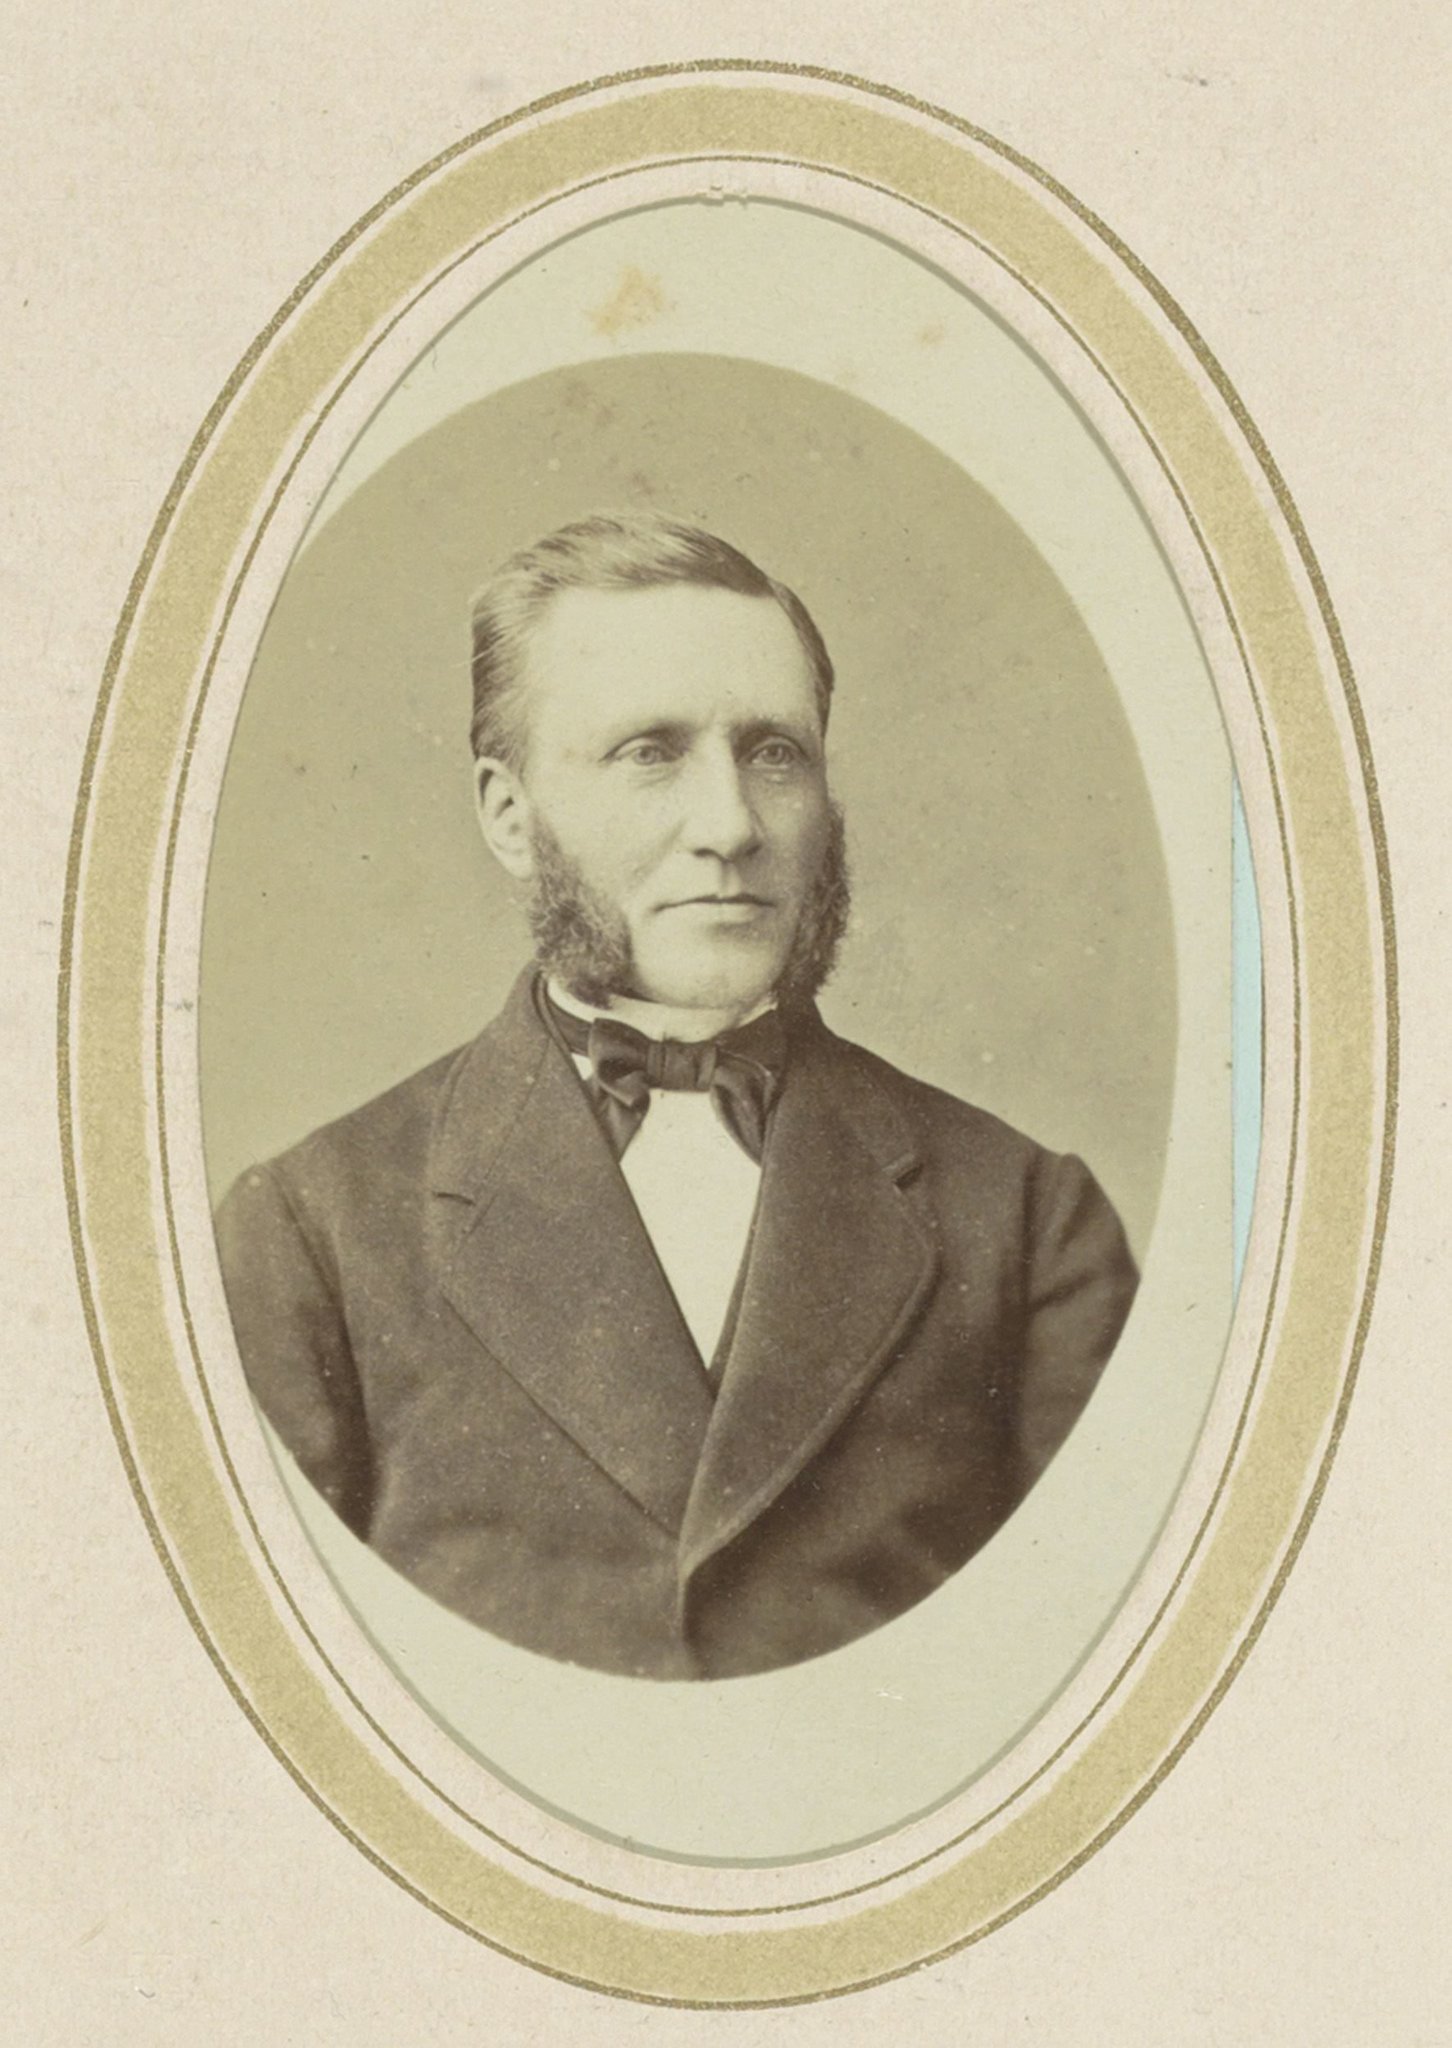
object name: photograph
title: Portret van een man met bakkebaarden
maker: johan christiaan reesinck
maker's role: fotograaf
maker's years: 1838-1922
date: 1866-1900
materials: cardboard, paper, photographic support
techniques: albumen print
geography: zutphen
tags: sideburns, historical persons, neck-gear ~ clothing, clothing for the upper part of the body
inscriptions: address: ‘Zutphen Berkelkade’, address: ‘Arnhem’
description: Onderdeel van Fotoalbum van een Nederlandse familie met 168 cartes-de-visite en kabinetfoto's.